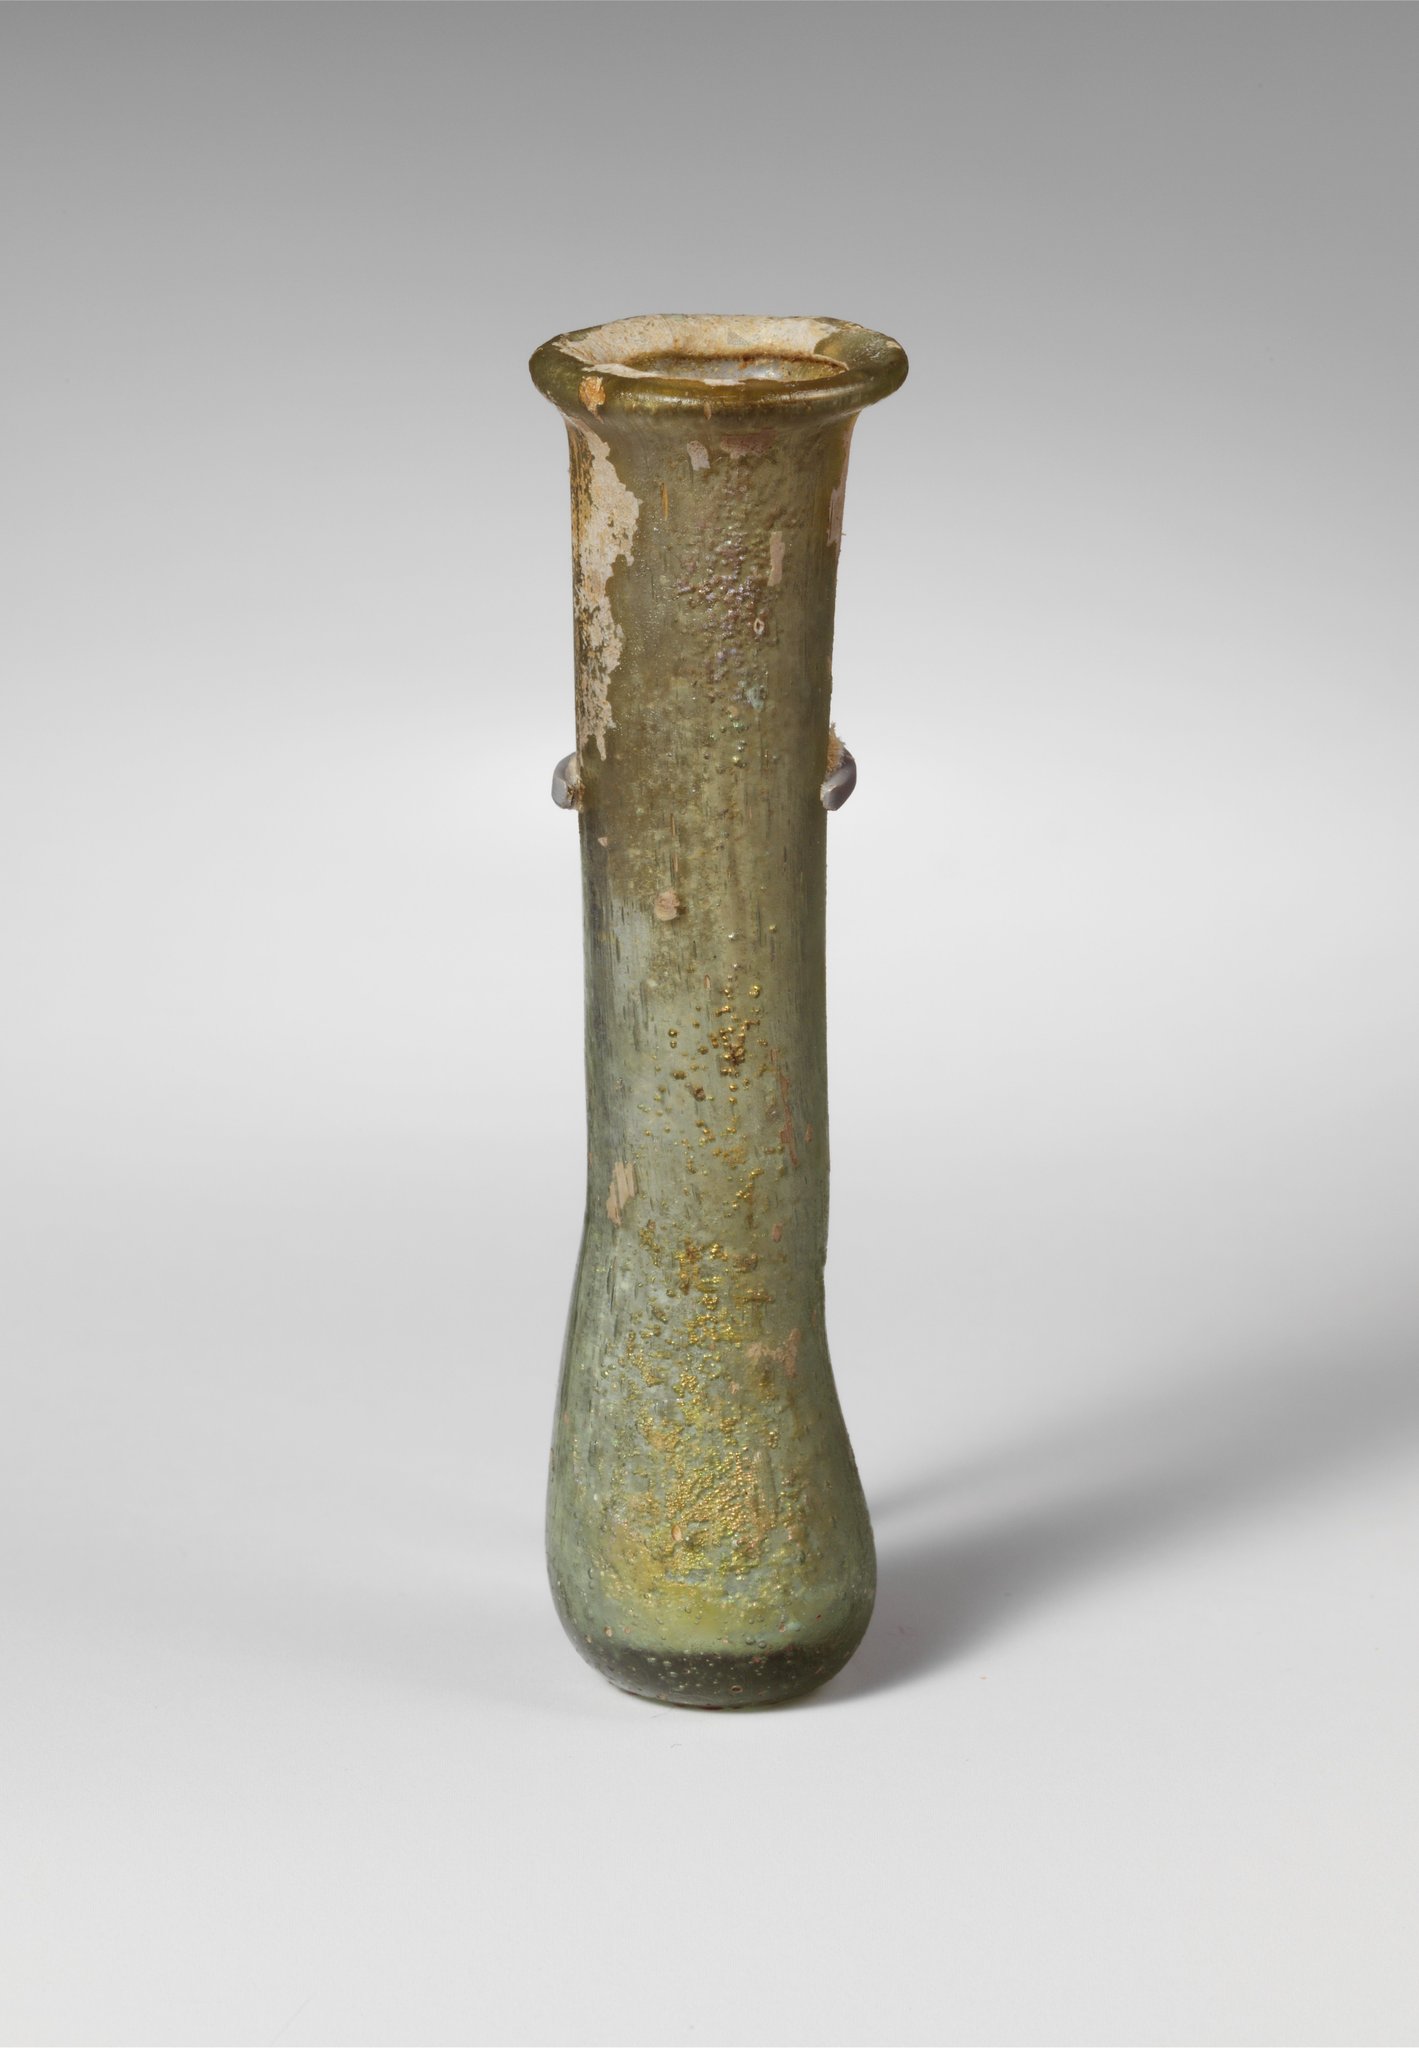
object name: perfume bottle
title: Glass perfume bottle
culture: roman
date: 1-200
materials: glass